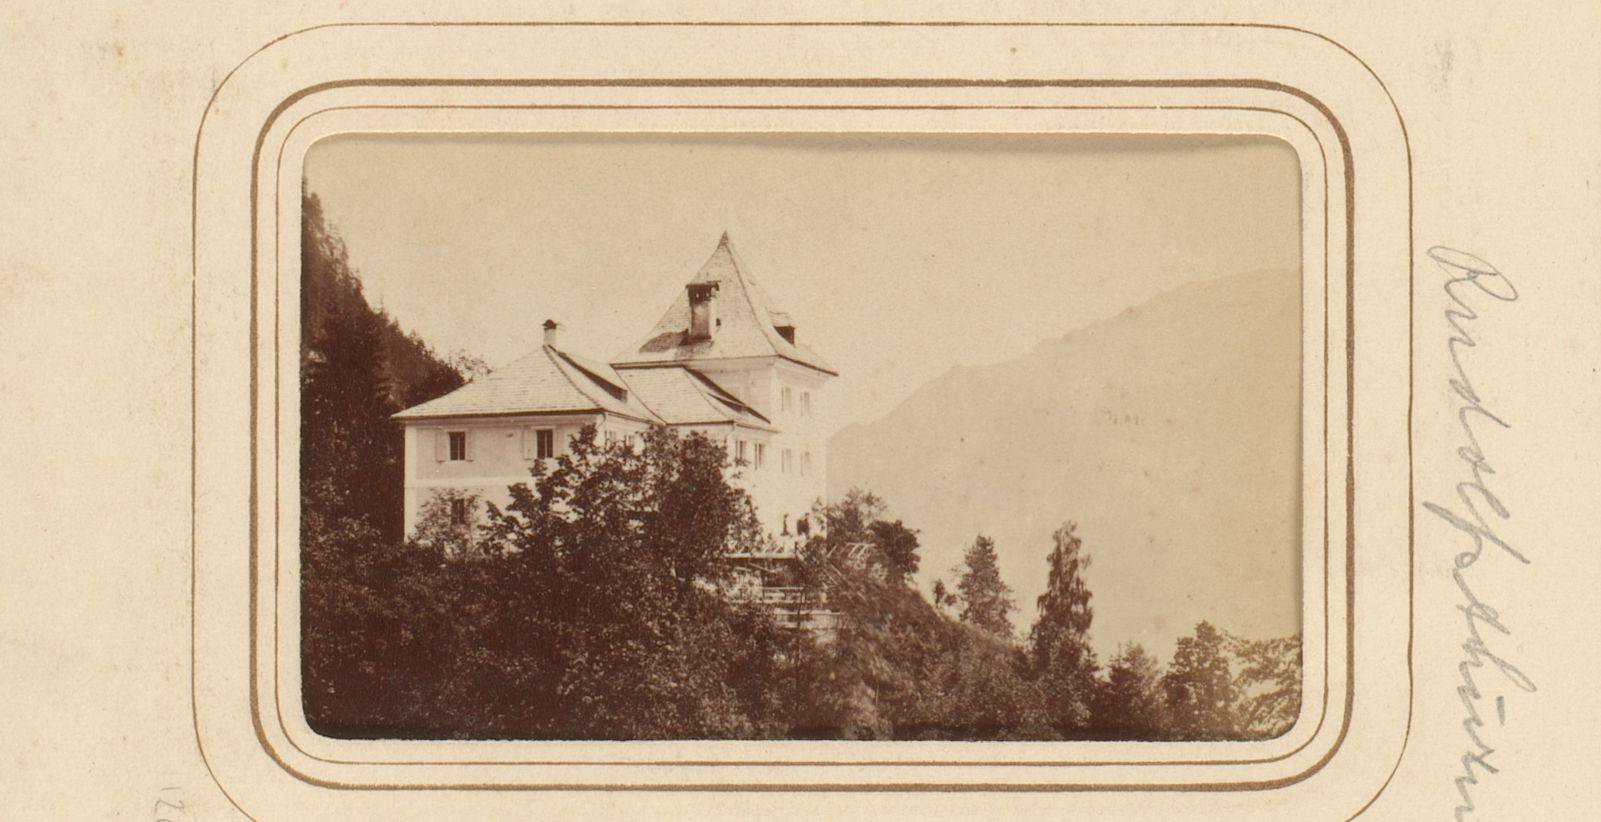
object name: carte de visite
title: Rudolfsturm te Hallstatt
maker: alois elfsenwenger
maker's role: fotograaf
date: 1865-1890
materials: cardboard, photographic support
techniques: albumen print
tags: trees, civic architecture; edifices; dwellings, mountains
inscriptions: annotation: ‘Rudolfsthurm’, name: ‘Fotg. A. Elfsenwenger’